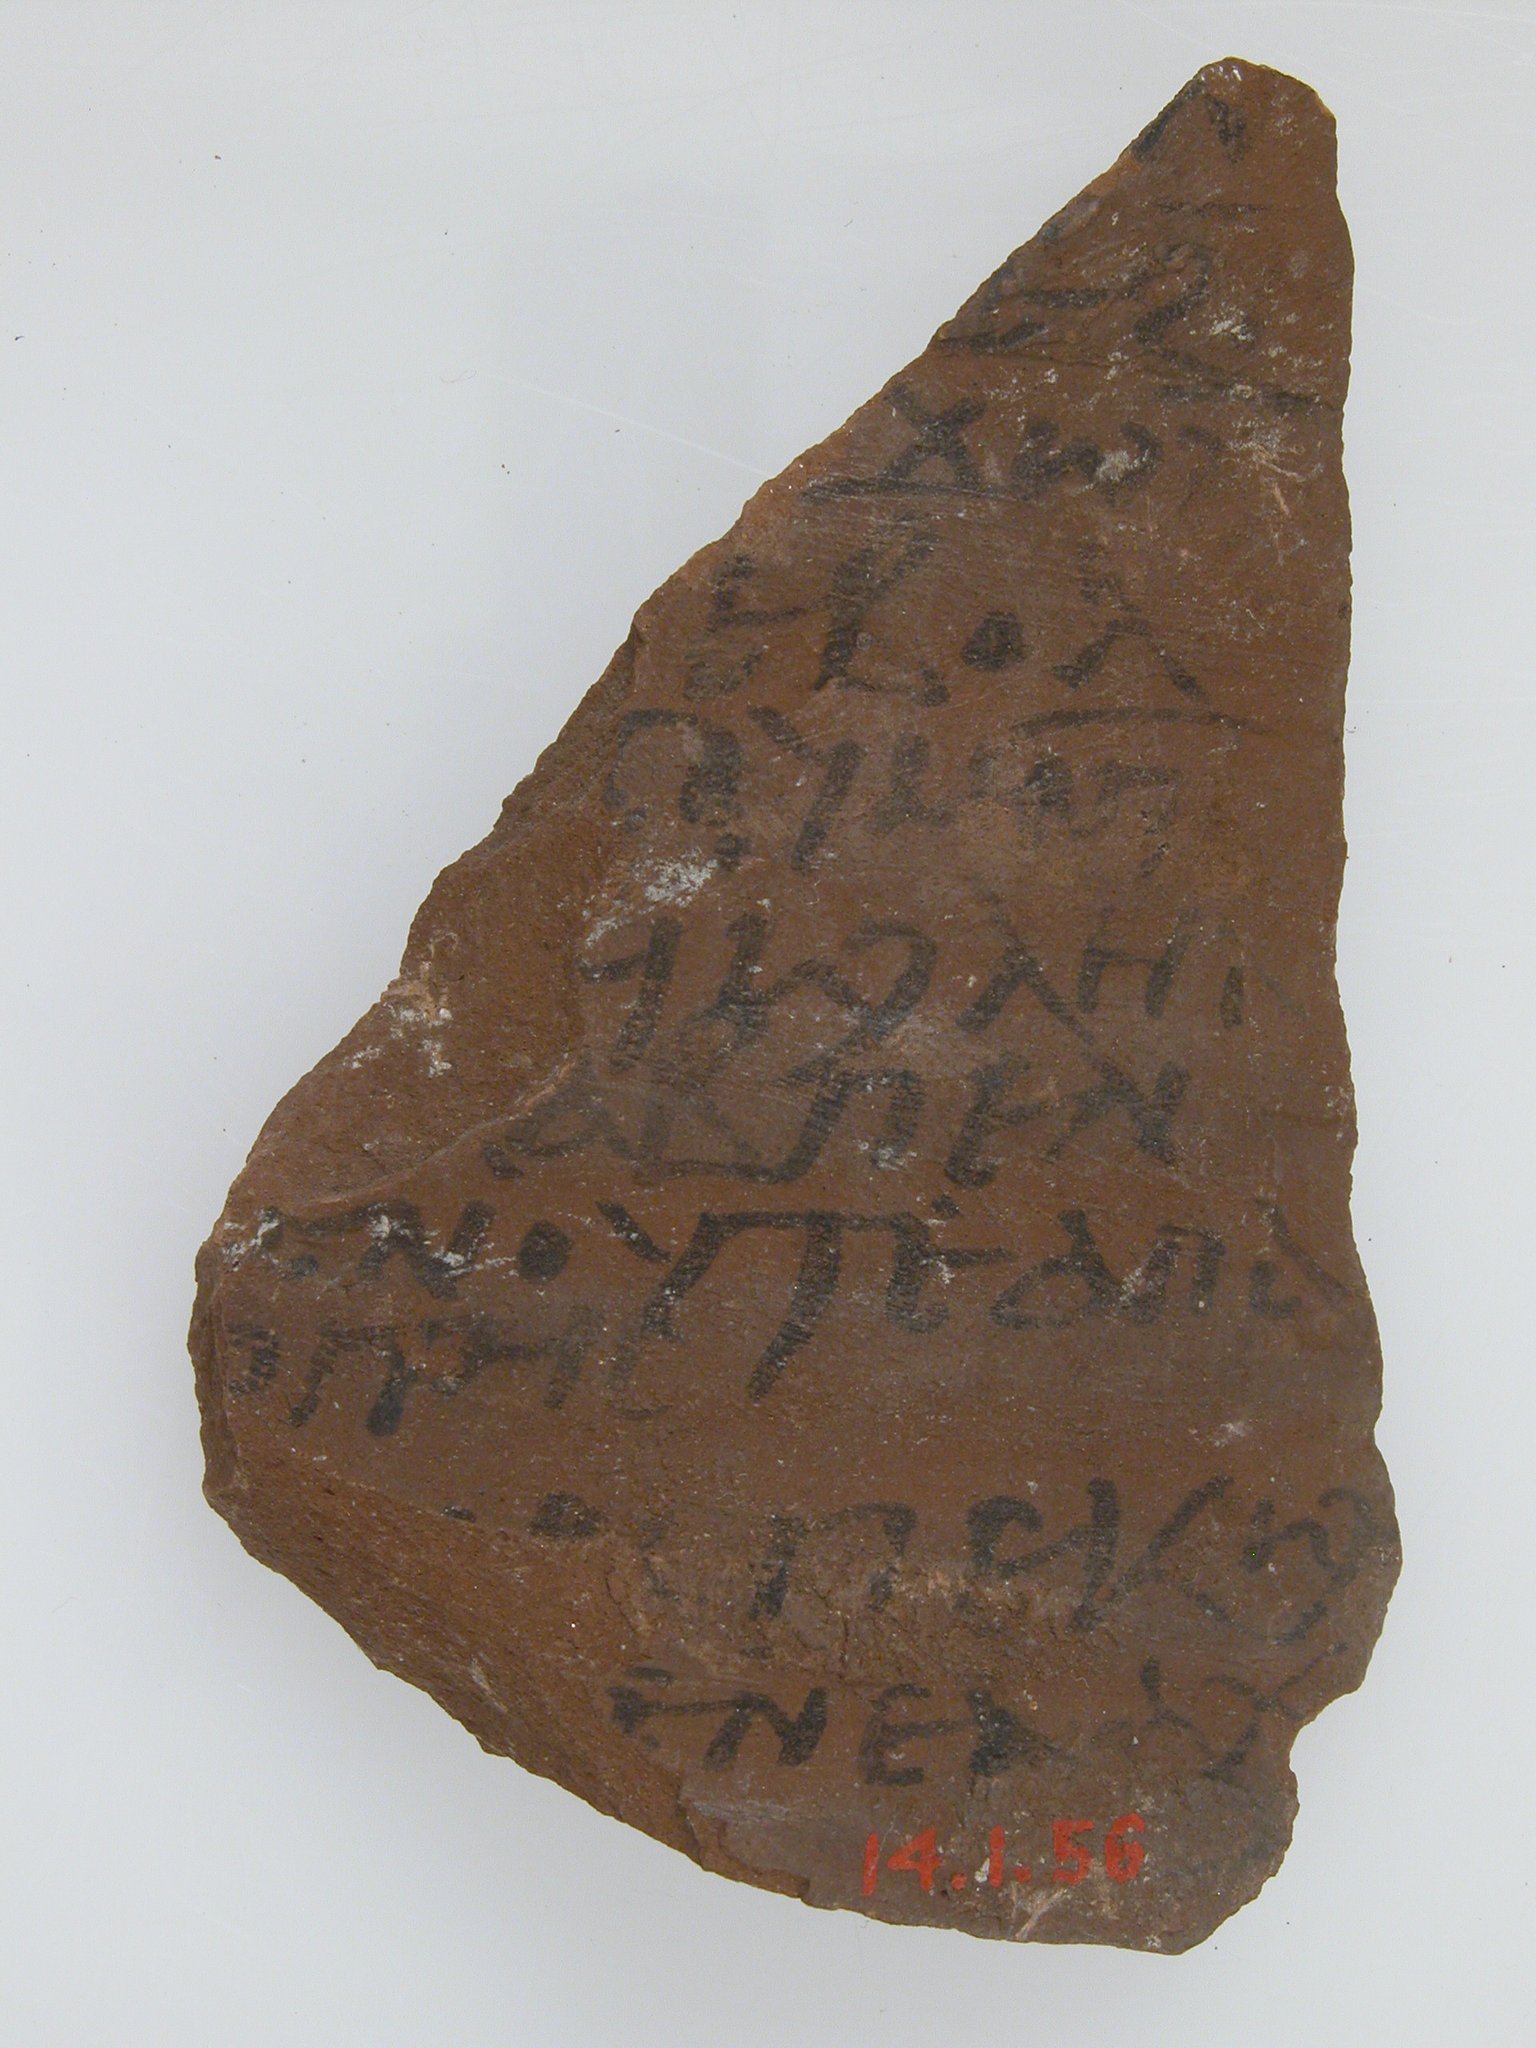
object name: ostrakon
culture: coptic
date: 600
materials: ink, pottery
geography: egypt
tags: coptic,documents